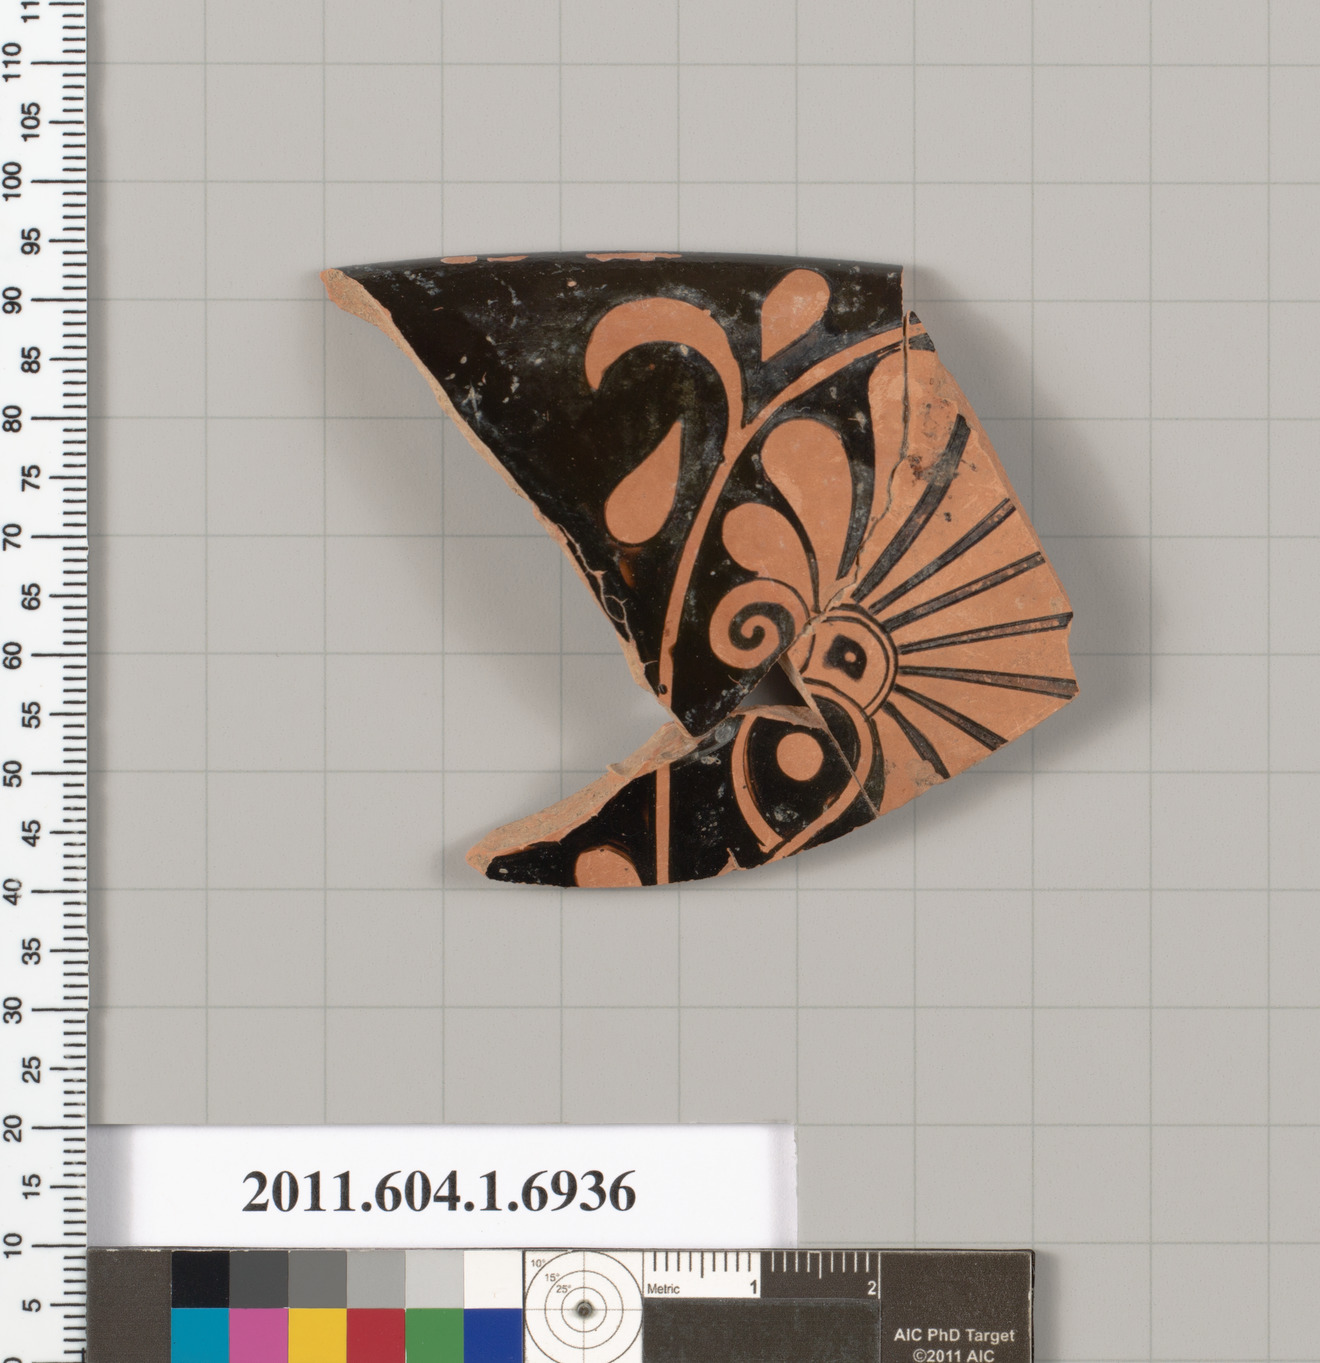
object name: kylix fragment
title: Terracotta rim fragment of a kylix (drinking cup)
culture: greek, attic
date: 490-470 BCE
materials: terracotta